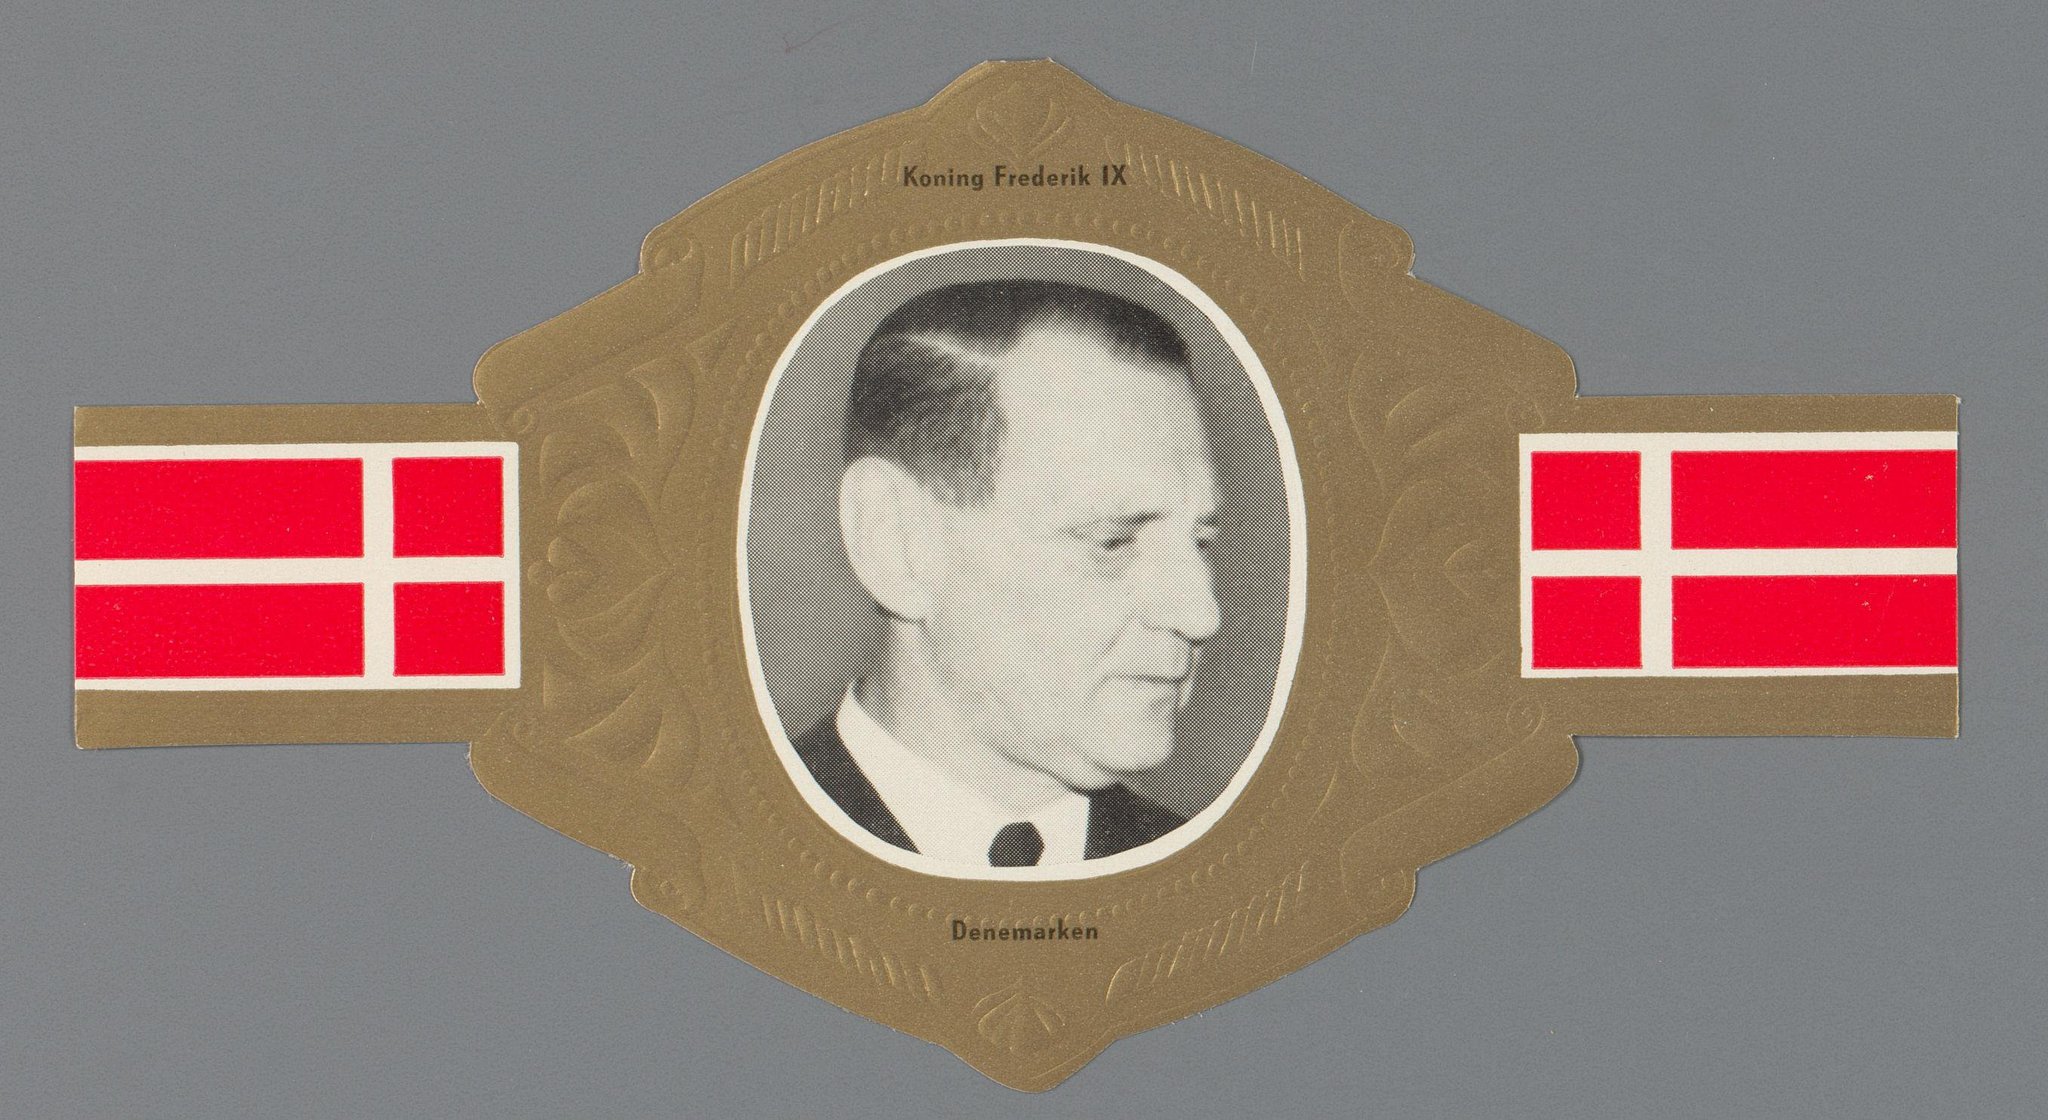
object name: photomechanical print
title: Koning Frederik IX Denemarken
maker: Anonymous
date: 1961-1963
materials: paper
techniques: blind stamped, printing block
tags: historical persons, king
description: Aan weerszijden van het portret is tweemaal de vlag van het land afgebeeld.